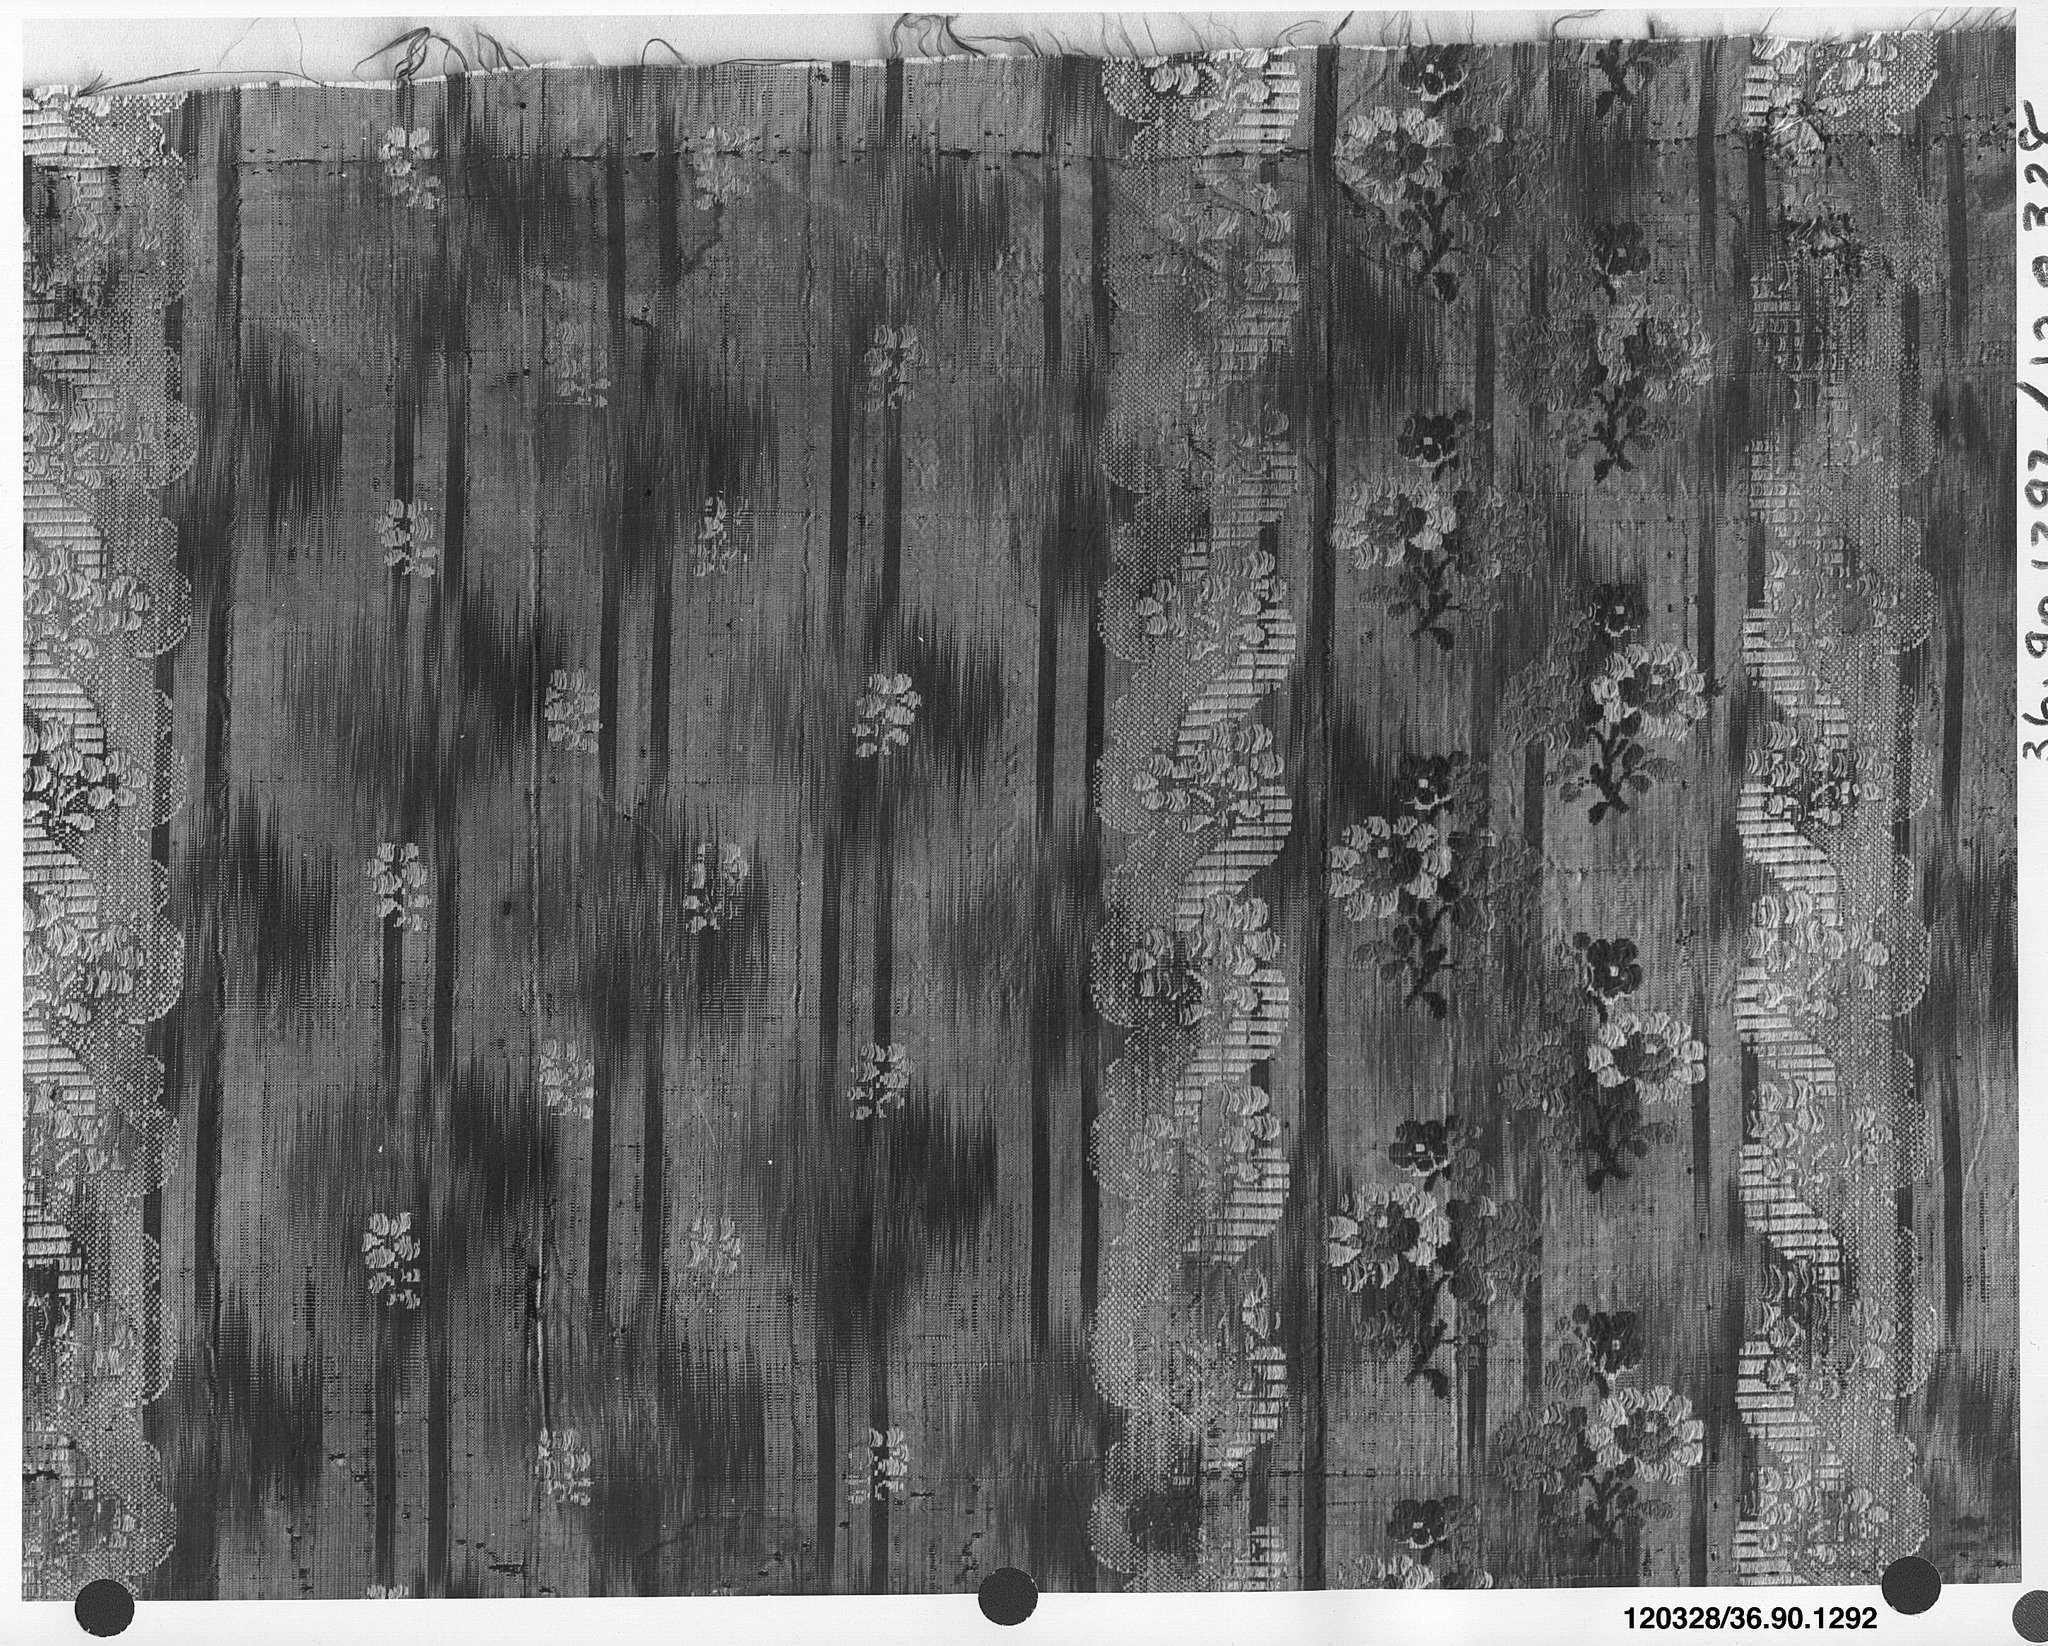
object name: piece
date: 1701-1800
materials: silk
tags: flowers,leaves